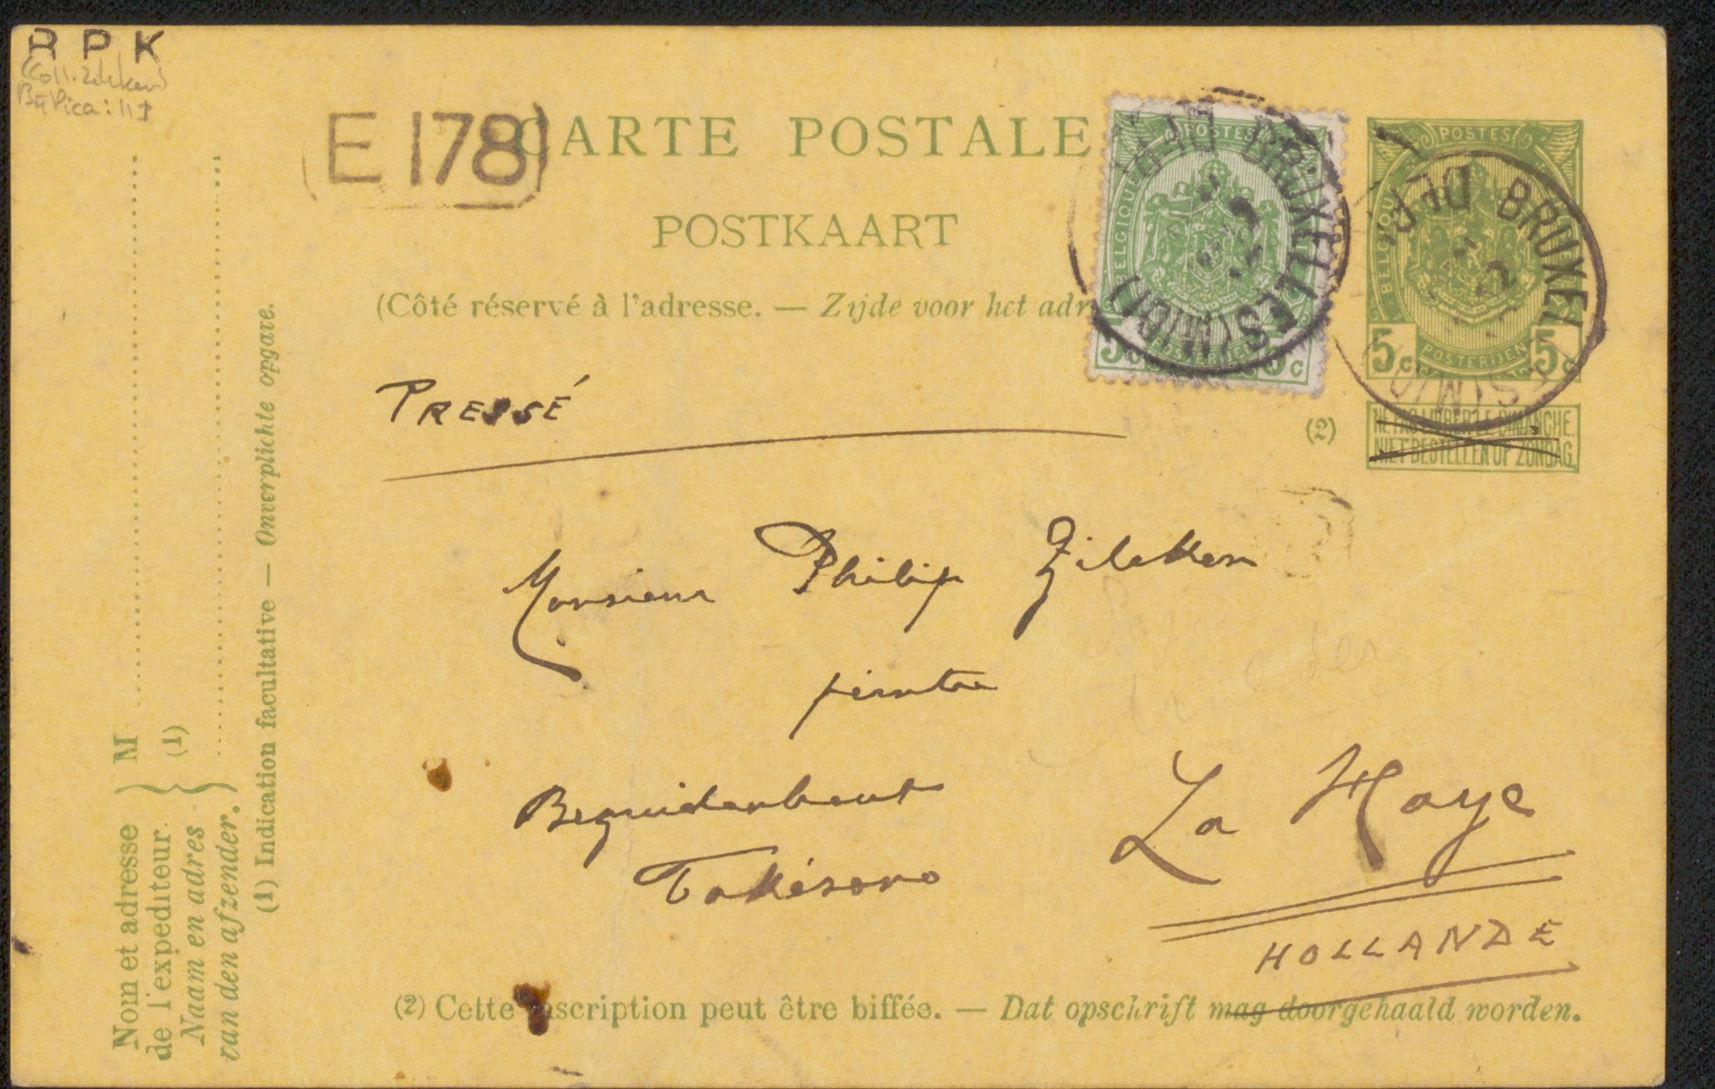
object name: postcard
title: Briefkaart aan Philip Zilcken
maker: vittorio pica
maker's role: criticus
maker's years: 1864-1930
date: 1874-1930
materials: cardboard, ink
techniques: pen, writing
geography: brussels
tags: the hague, painter, draughtsman, philip zilcken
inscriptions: collector's mark: ‘RPK’